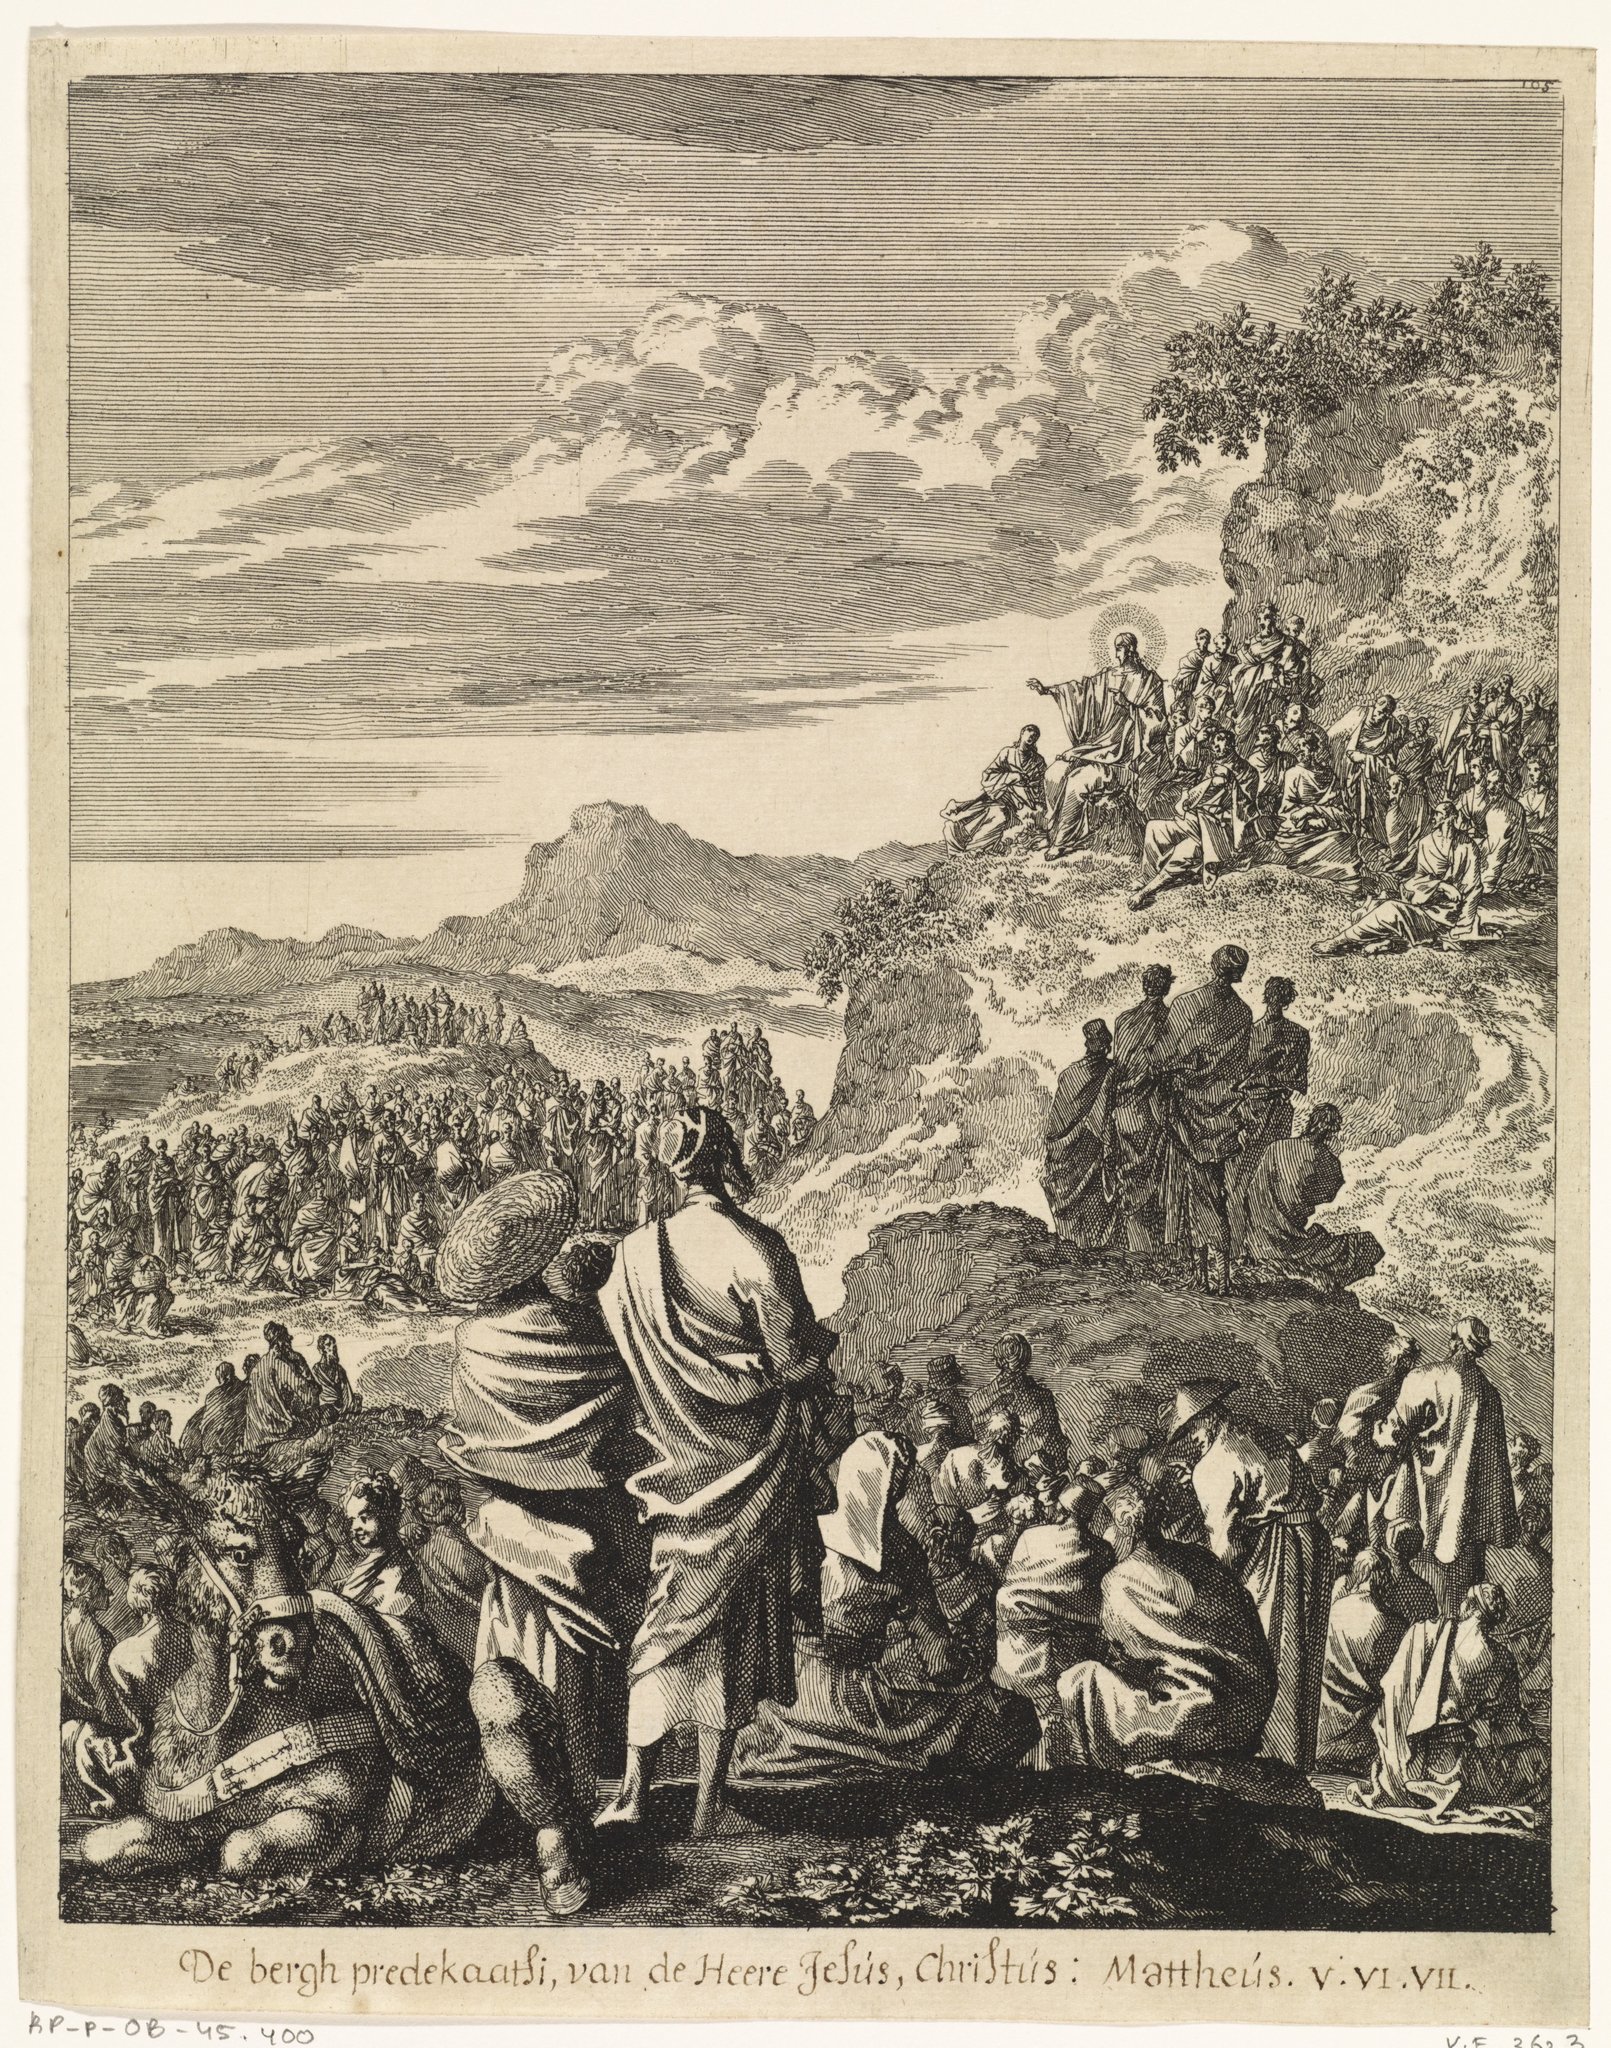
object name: print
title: Bergrede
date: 1708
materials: paper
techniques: etching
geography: amsterdam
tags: beatitudes of the sermon on the mount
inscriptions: collector's mark: Lugt 2228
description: Proefdruk van een prent welke is opgenomen als illustratie in: Historiae Celebriores Veteris Testamenti. Christoph Weigel, 1708.